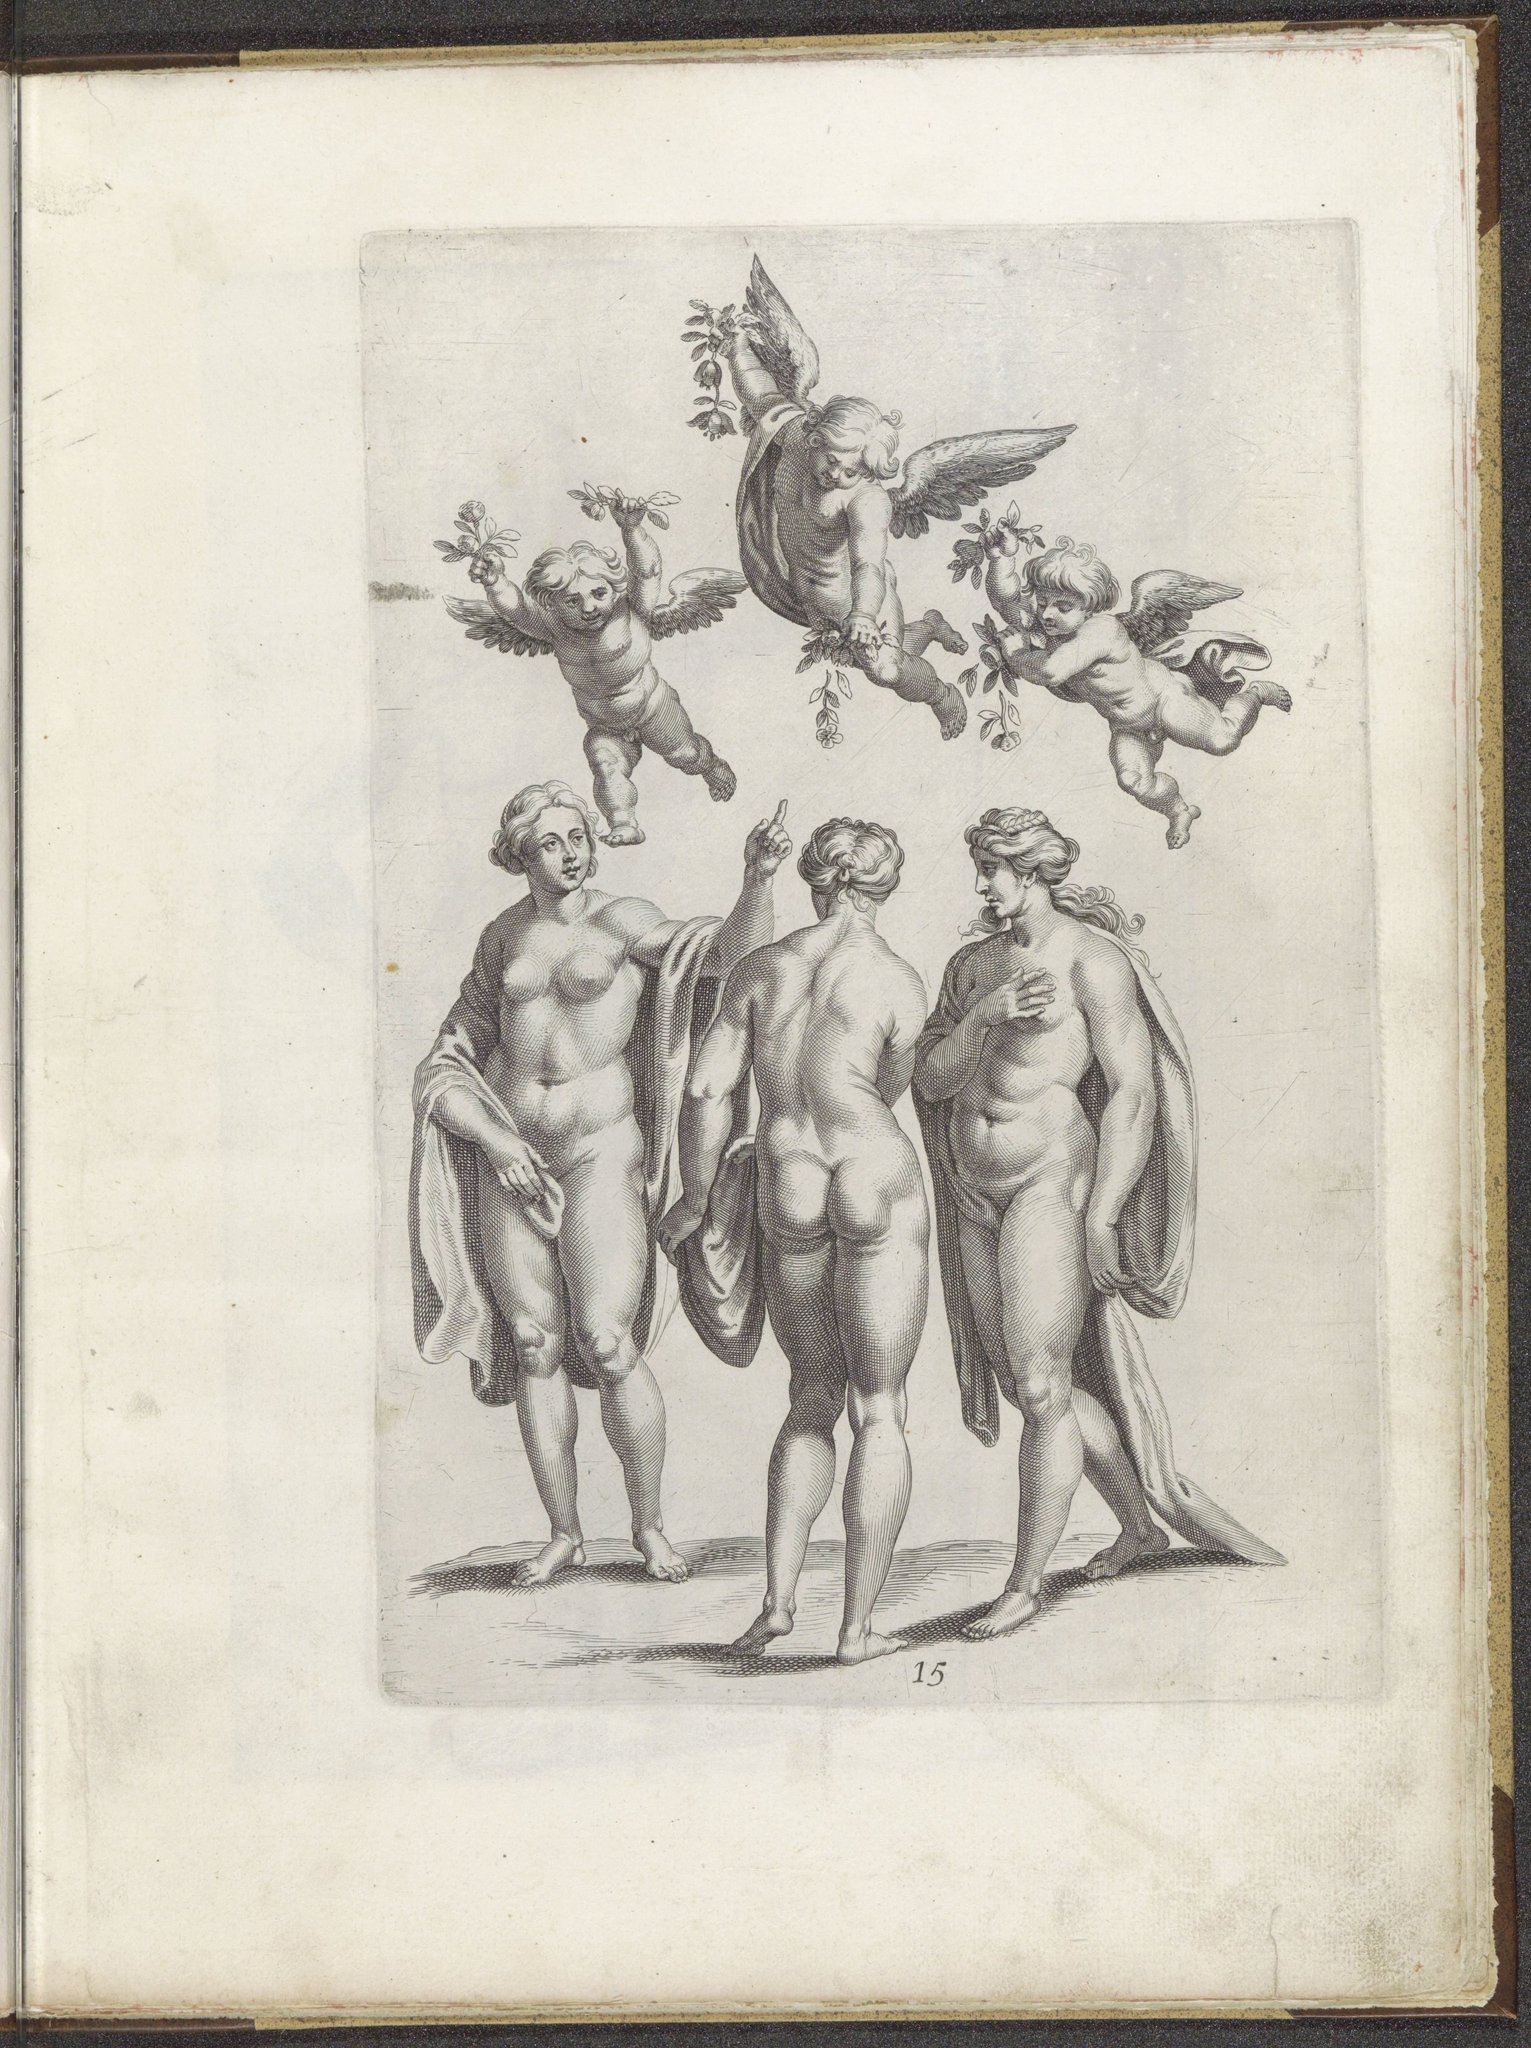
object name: album leaf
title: Varie figvre academiche / Diversche figvren wt de academia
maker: pieter de jode (i)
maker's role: draughtsman, print maker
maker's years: 1570-1634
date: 1629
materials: paper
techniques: engraving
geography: antwerp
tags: graces (charites), generally three in number; 'gratie' (ripa), cupids: 'amores', 'amoretti', 'putti'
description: Tekenvoorbeeld. De drie gratiën. Boven hen vliegen drie putti met bloemen in de handen. Deze prent maakt deel uit van een album.